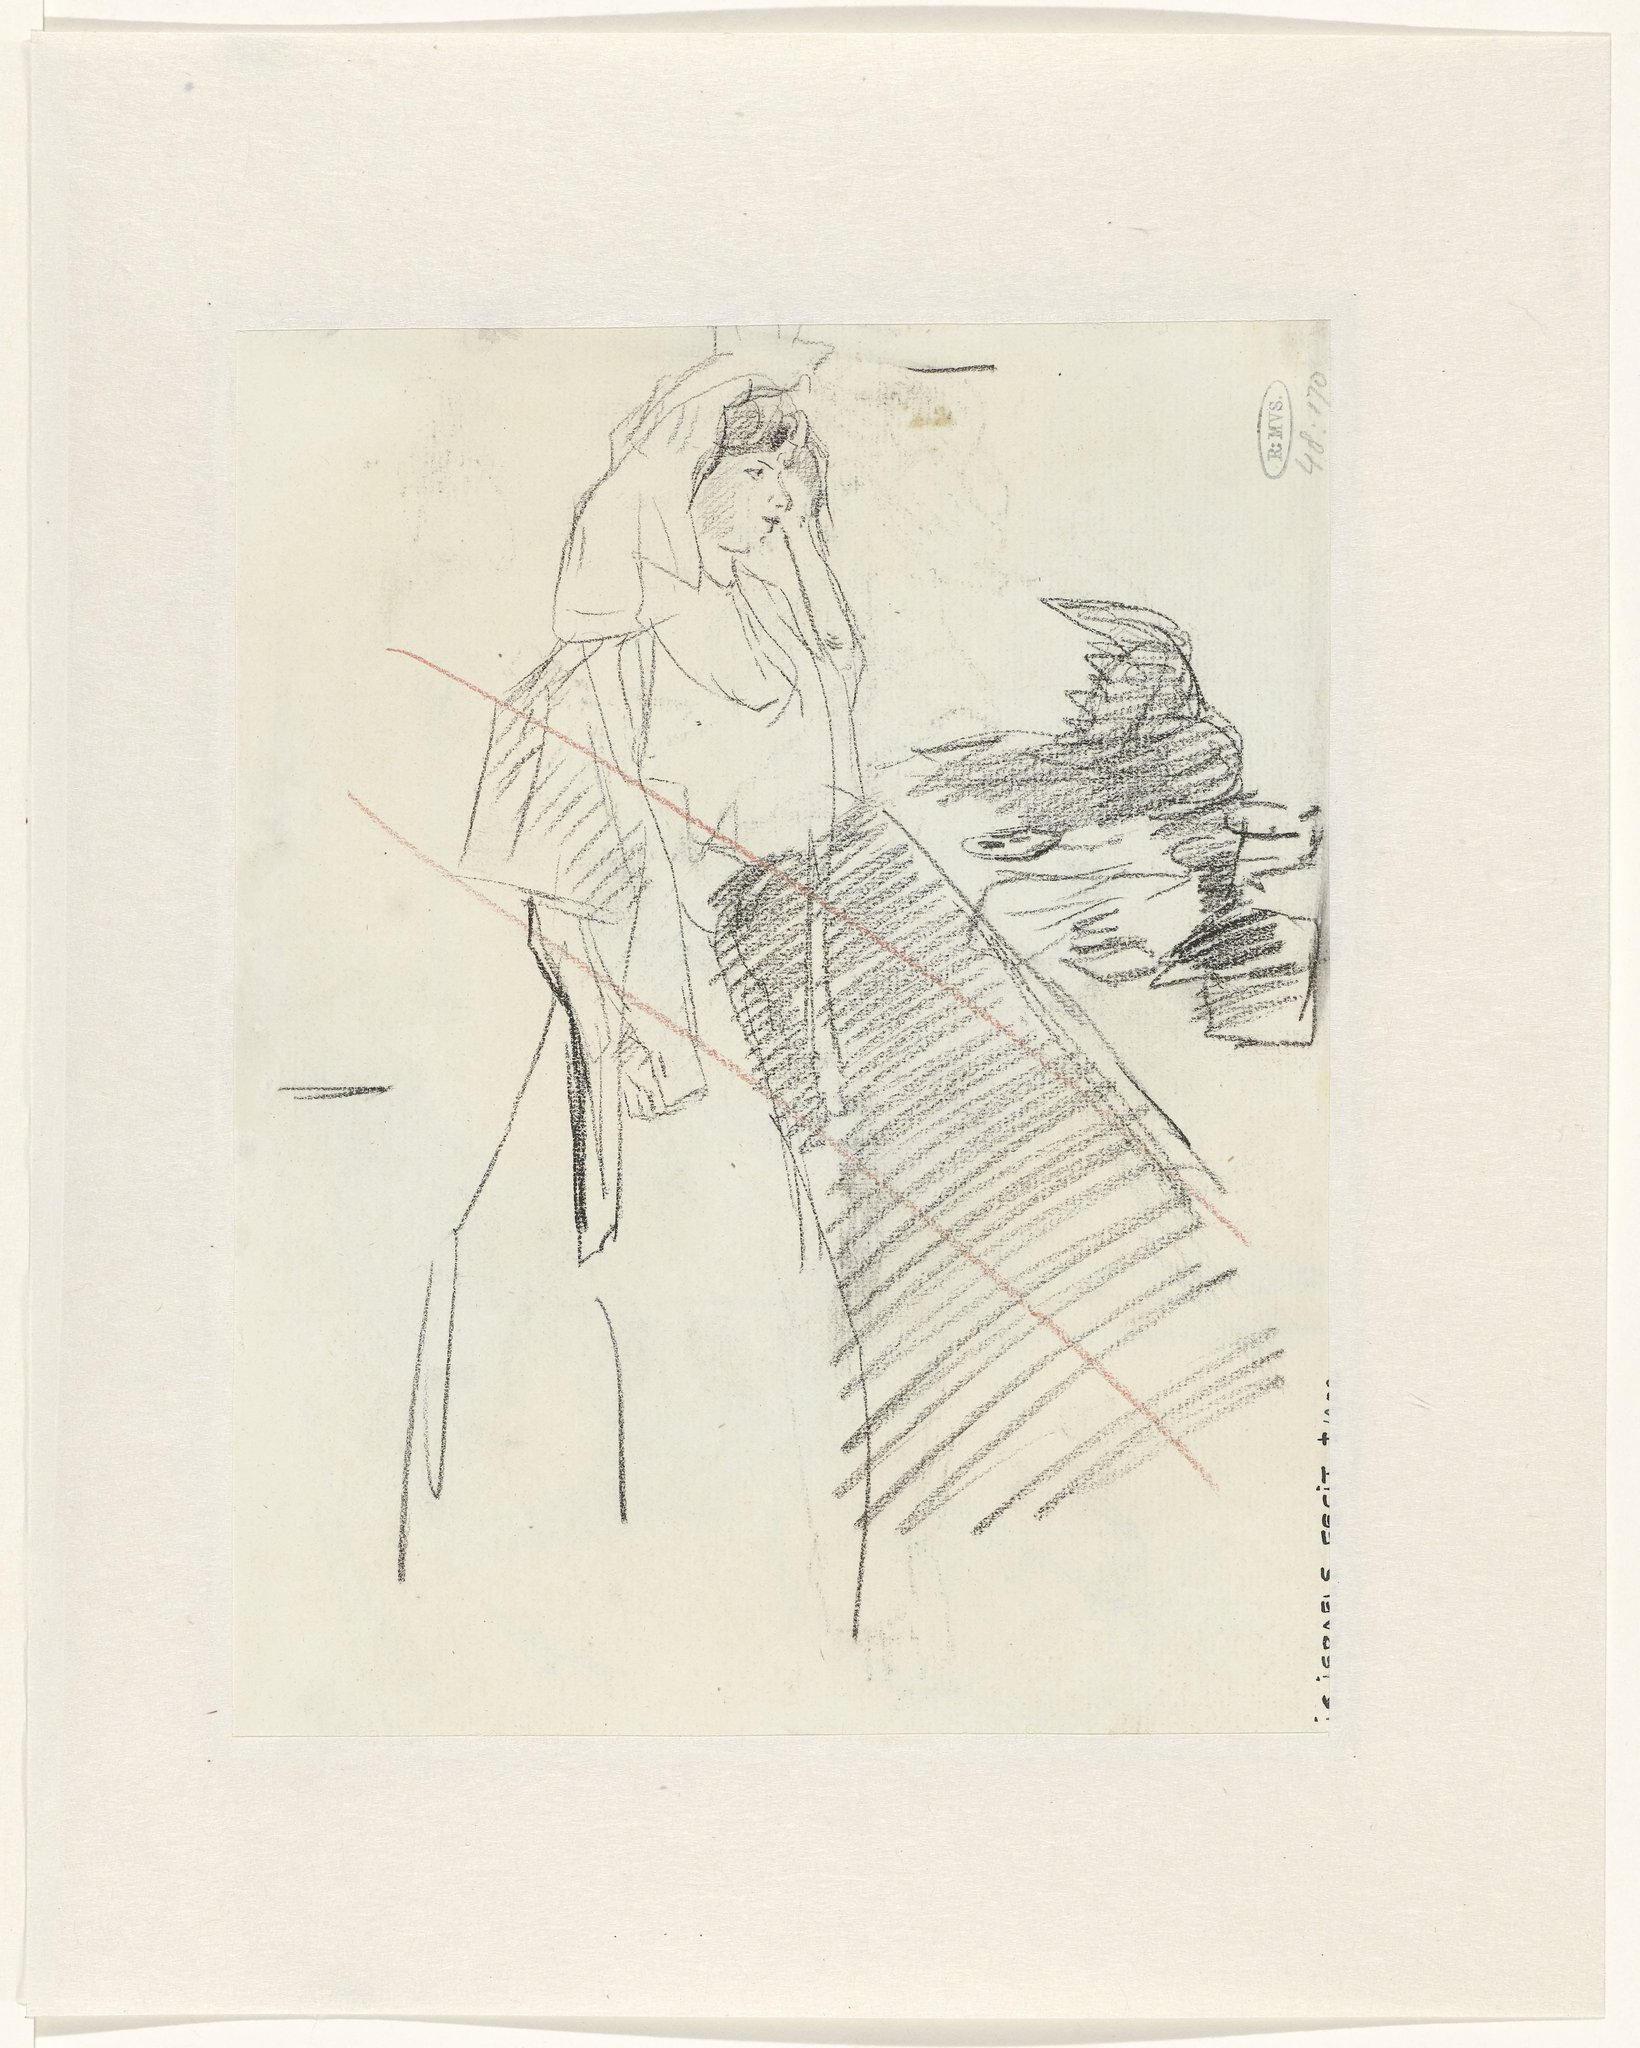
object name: drawing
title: Staande vrouw, naar rechts (doorgestreept)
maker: isaac israels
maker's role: draughtsman, painter, print maker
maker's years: 1865-1934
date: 1900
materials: chalk, paper